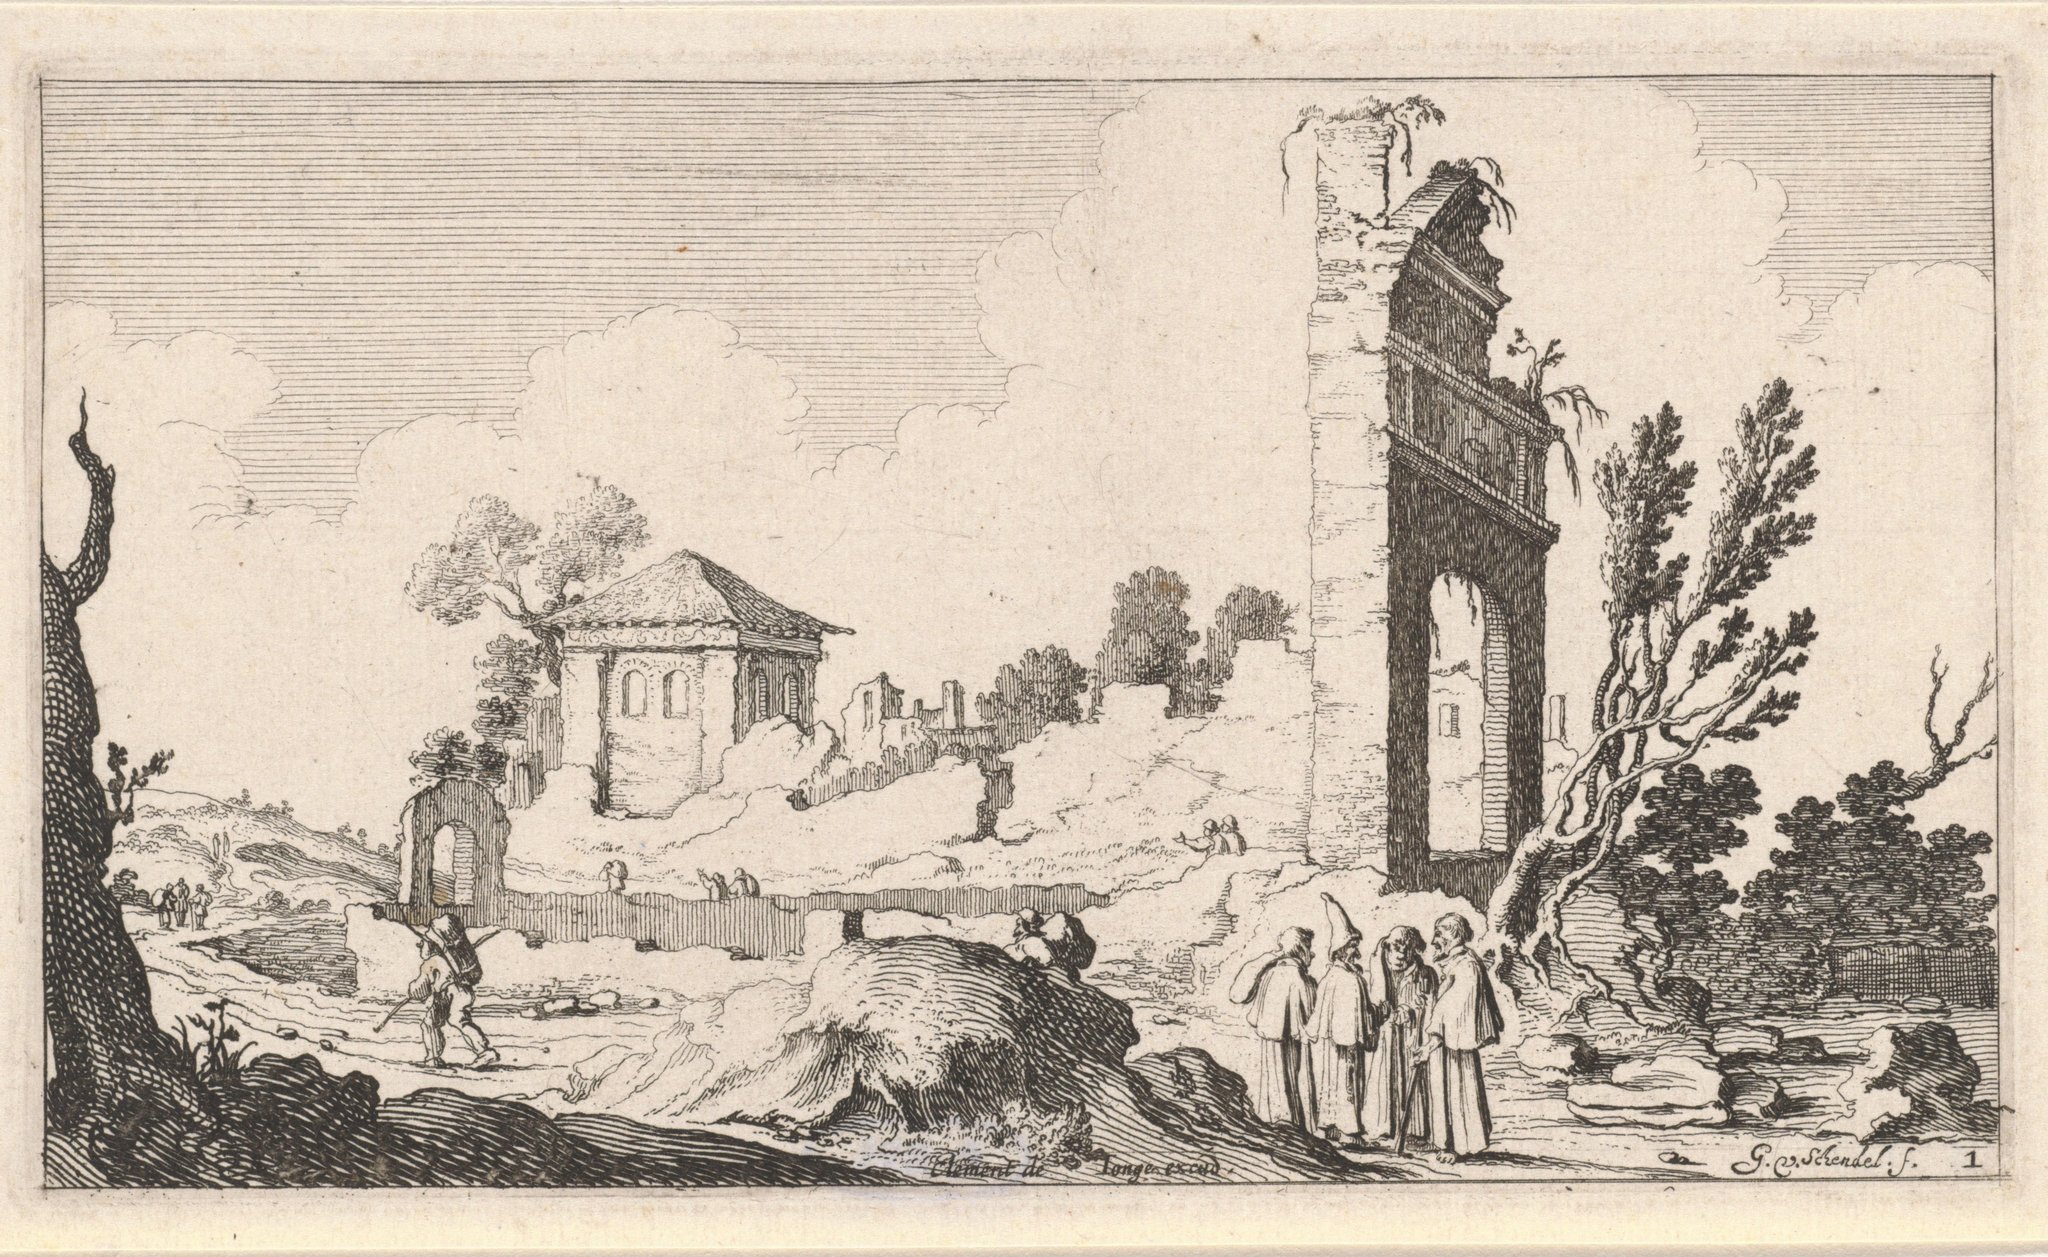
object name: print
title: Twaalf landschappen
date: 1640-1670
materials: paper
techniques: etching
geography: amsterdam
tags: landscape with ruins, monk(s), friar(s)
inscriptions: collector's mark: Lugt 2228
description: Glooiend landschap met een vervallen muur en een poort in een boog. Op de voorgrond vier monniken en een landweg met een wandelaar. De prent maakt deel uit van een serie van twaalf landschappen.